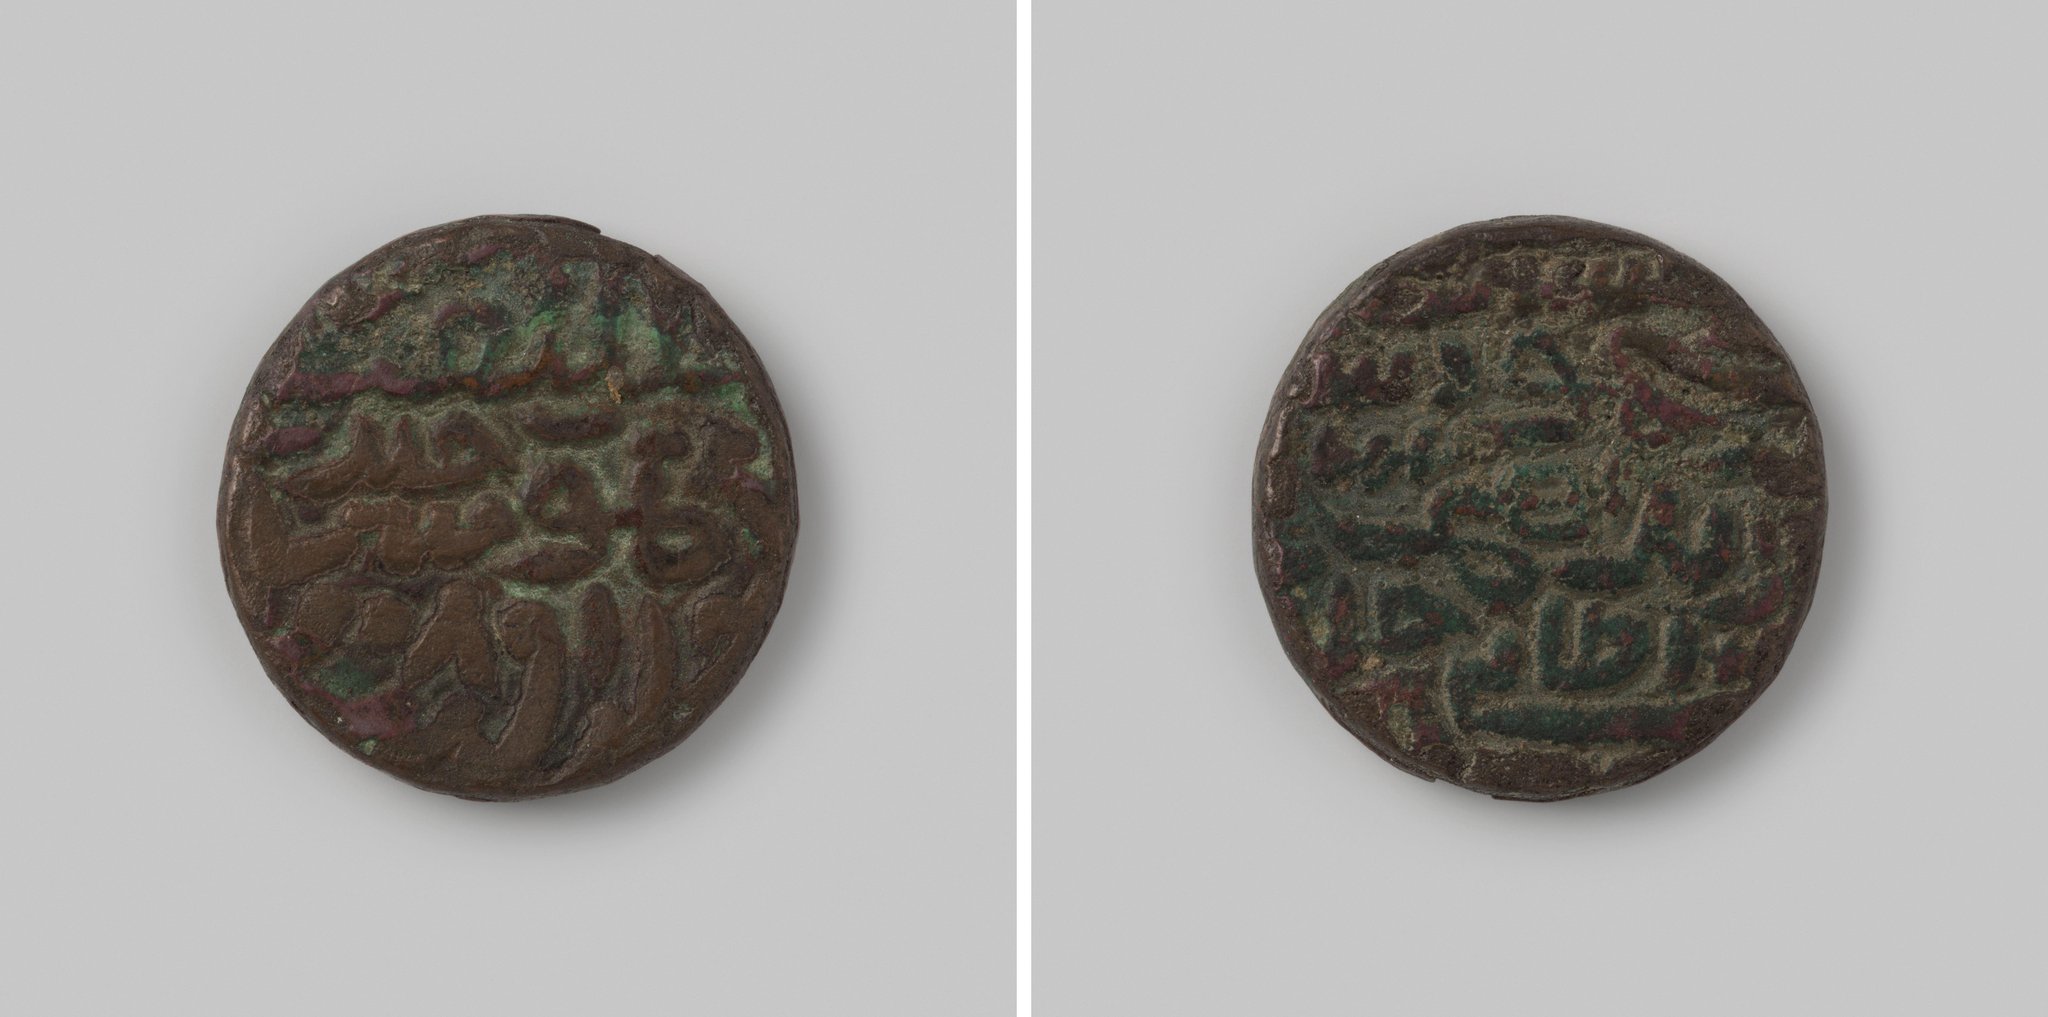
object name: coin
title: Paisa van de eerste grootte uit het koninkrijk Jaunpur in India van Husain Sjah, 868 [=1463]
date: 1463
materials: copper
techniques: striking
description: Koperen munt. Voorzijde: in Arabische lettertekens opschrift met naam van de sjah. Keerzijde: in Arabische lettertekens in vier regels opschrift met jaartal-aanduiding.